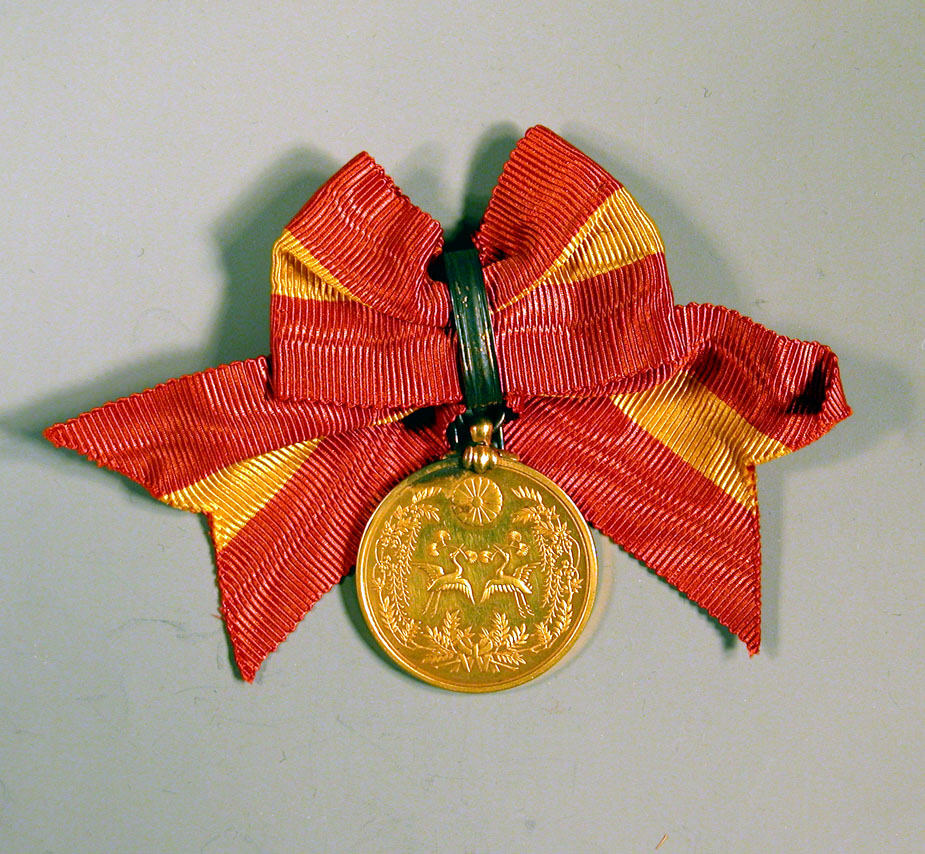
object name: medal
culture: japanese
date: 1867-1900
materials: gold